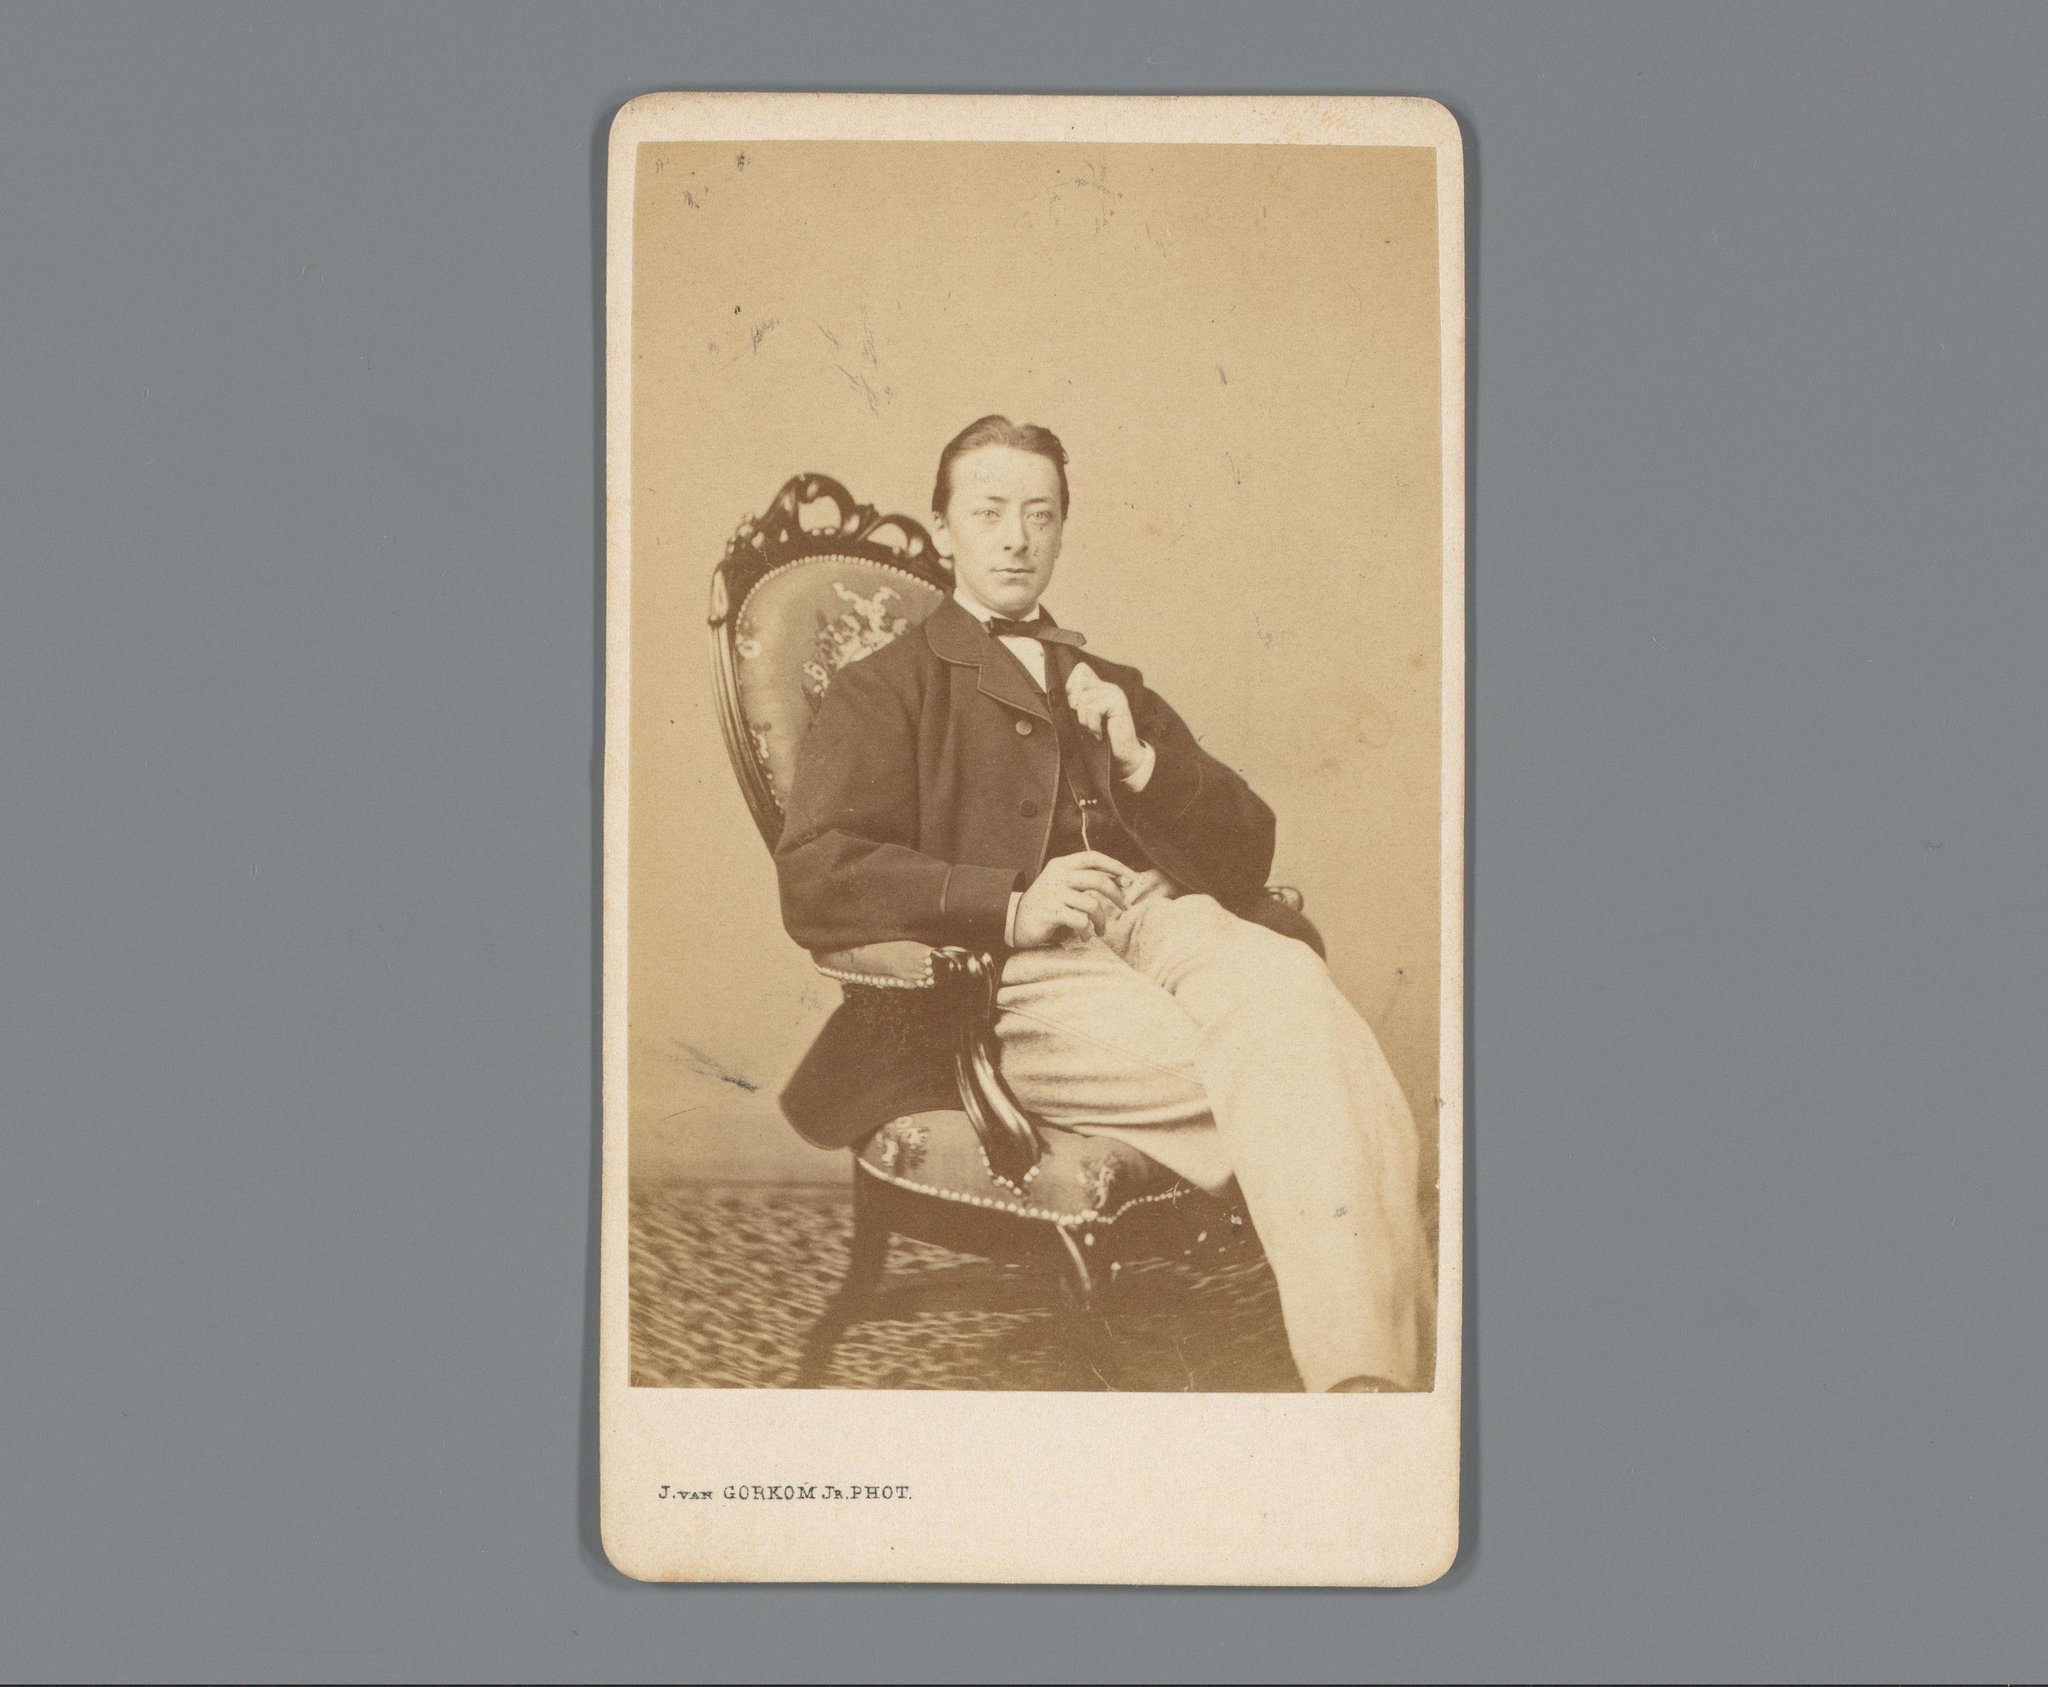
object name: photograph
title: Portret van M.A. Swellengrebel.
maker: jacobus van gorkom (jr.)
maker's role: print maker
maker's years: 1827-1880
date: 1862-1871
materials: cardboard, photographic support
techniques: albumen print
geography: rotterdam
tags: rotterdam, haarlem, cigar, historical persons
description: Portret van Mari Adriaan Swellengrebel, zittend in een stoel, een rokende sigaar in de hand.